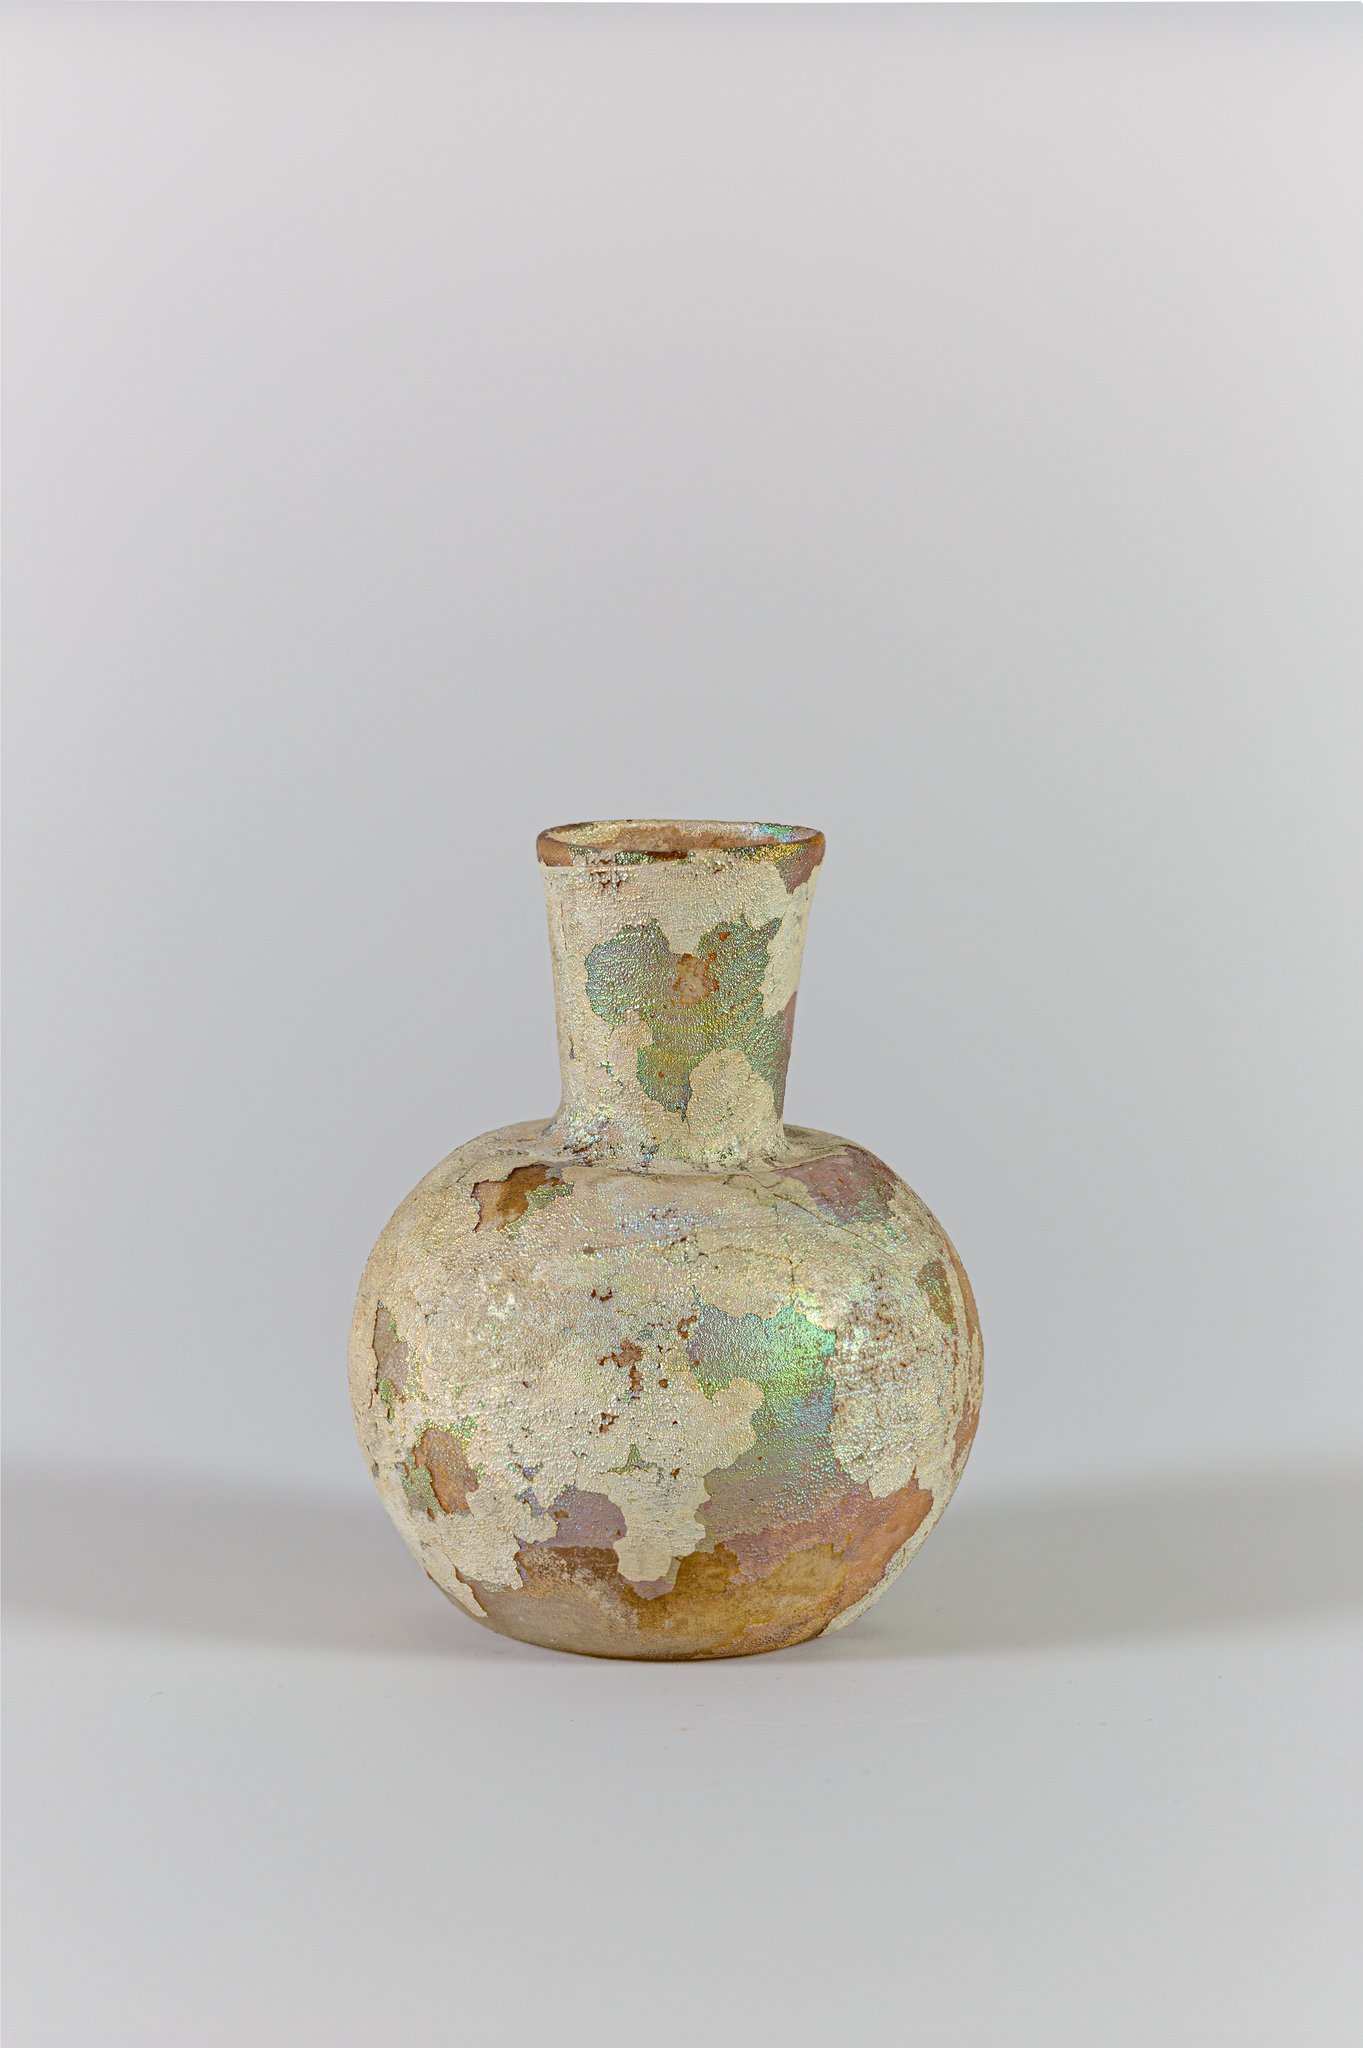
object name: flask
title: Glass flask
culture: roman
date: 201-300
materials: glass